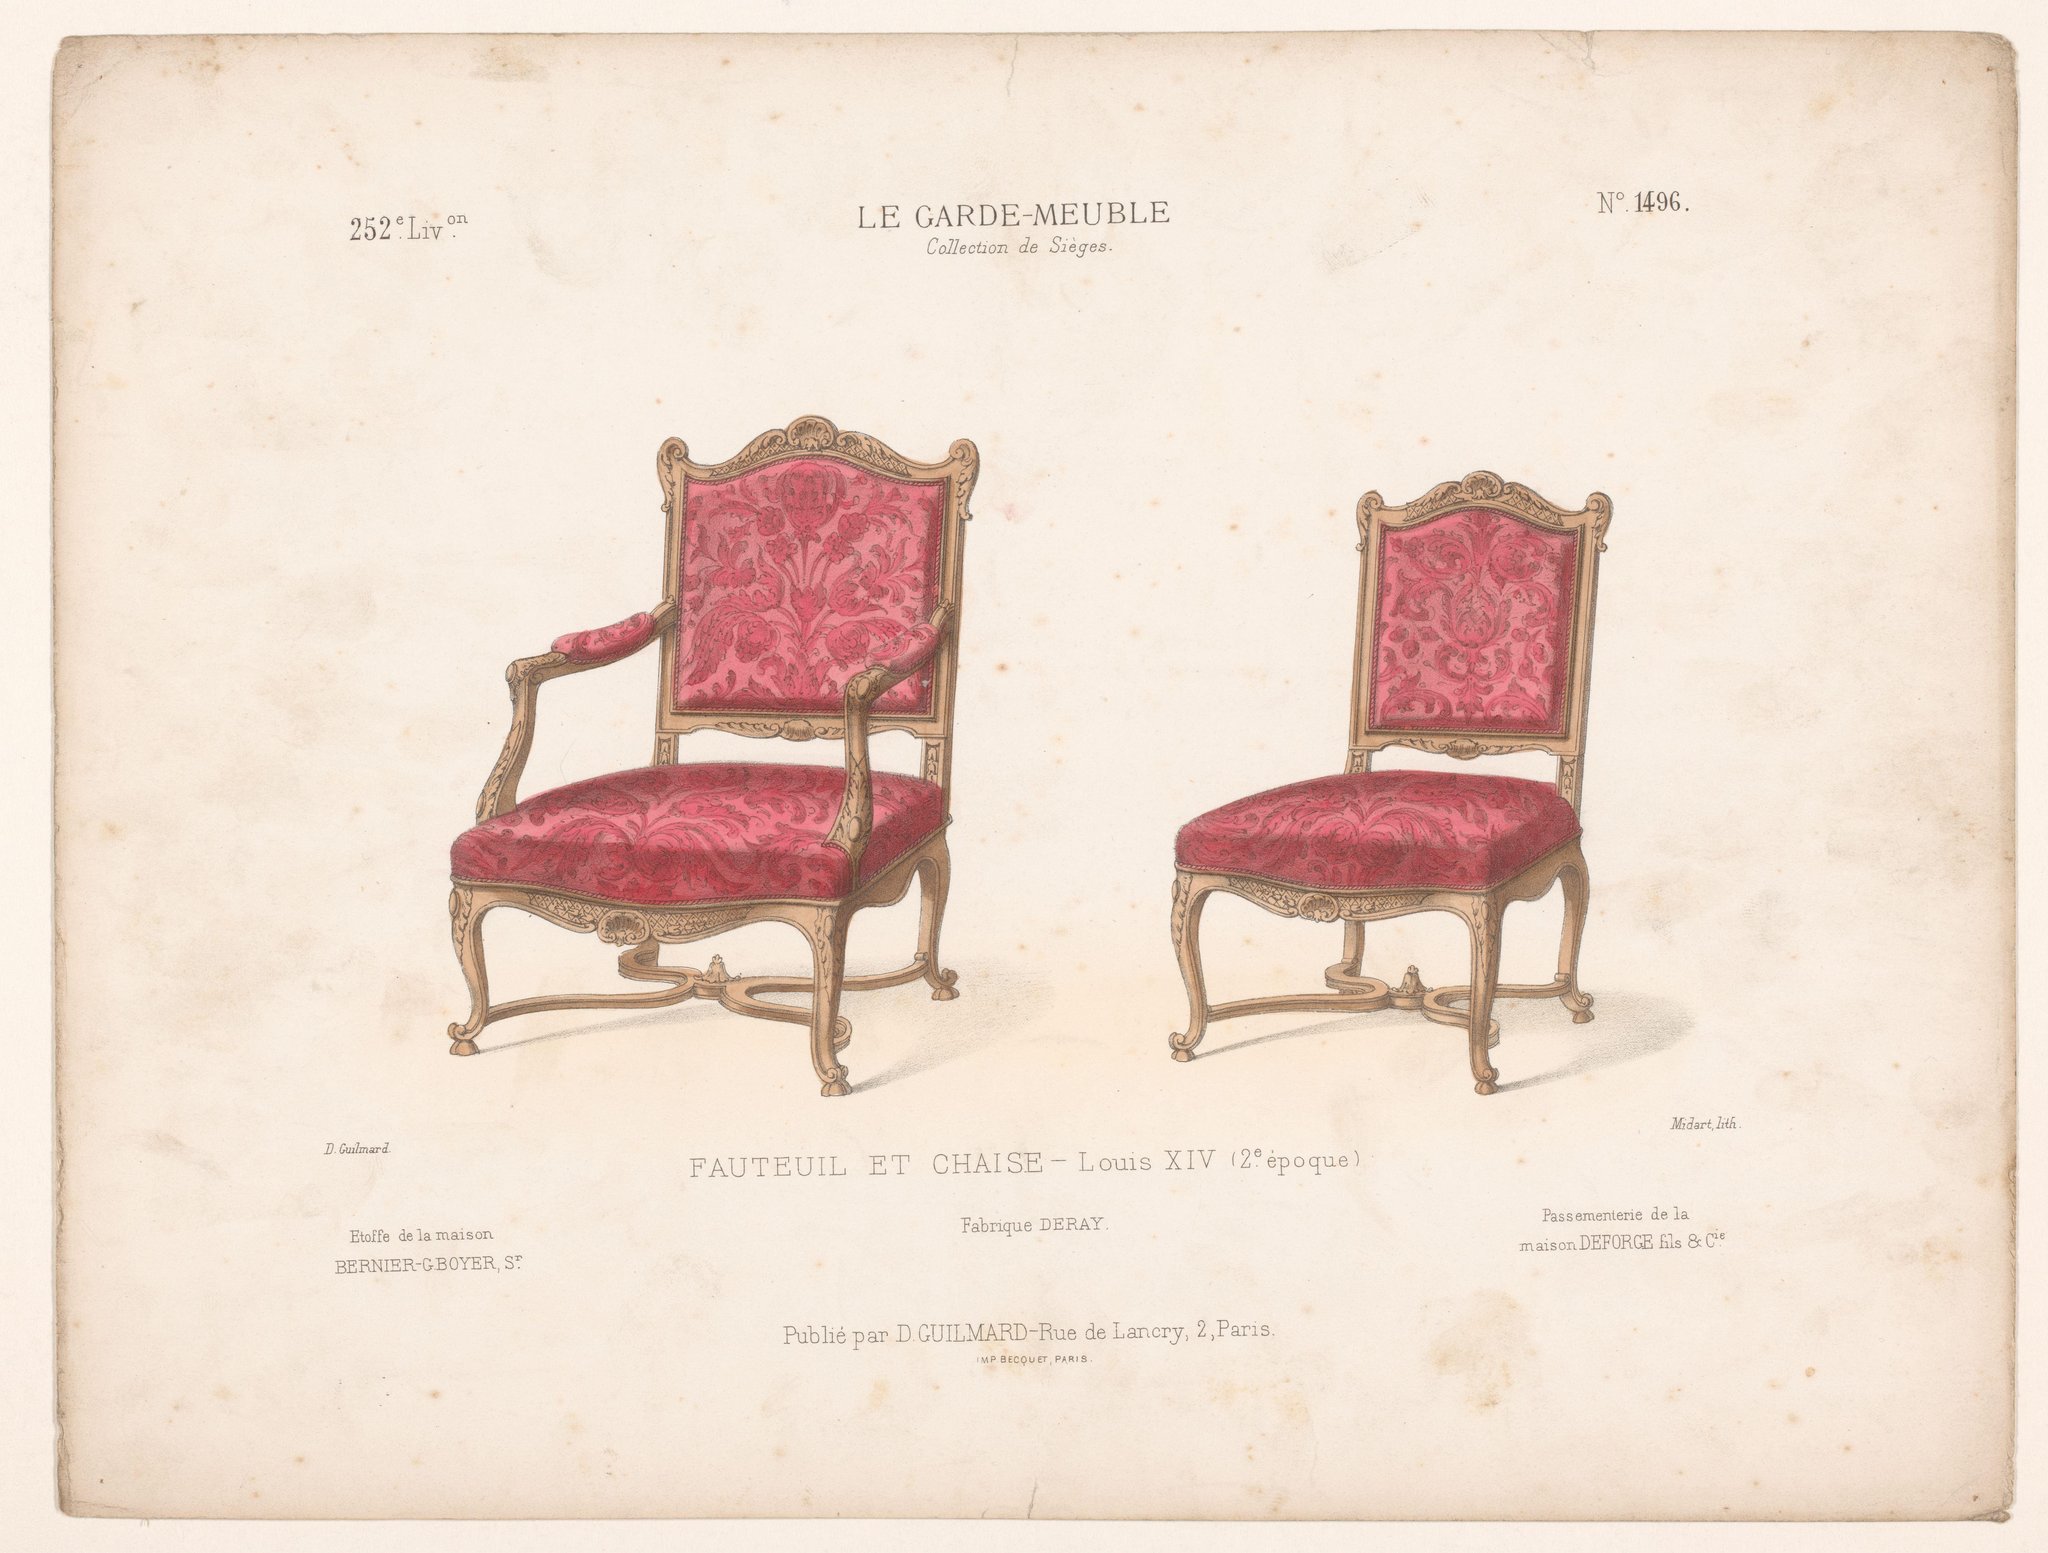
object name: print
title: Le garde-meuble / Collection de Sièges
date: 1839-1885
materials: paper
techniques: hand coloring, lithograph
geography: paris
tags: seating furniture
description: Ieder Livraison in de serie Le Garde-Meuble bevat negen platen: drie 'sièges' (zitmeubels), drie 'meubles' (diverse meubels zoals tafels en kasten) en drie 'tentures' (gordijnen en draperieën).